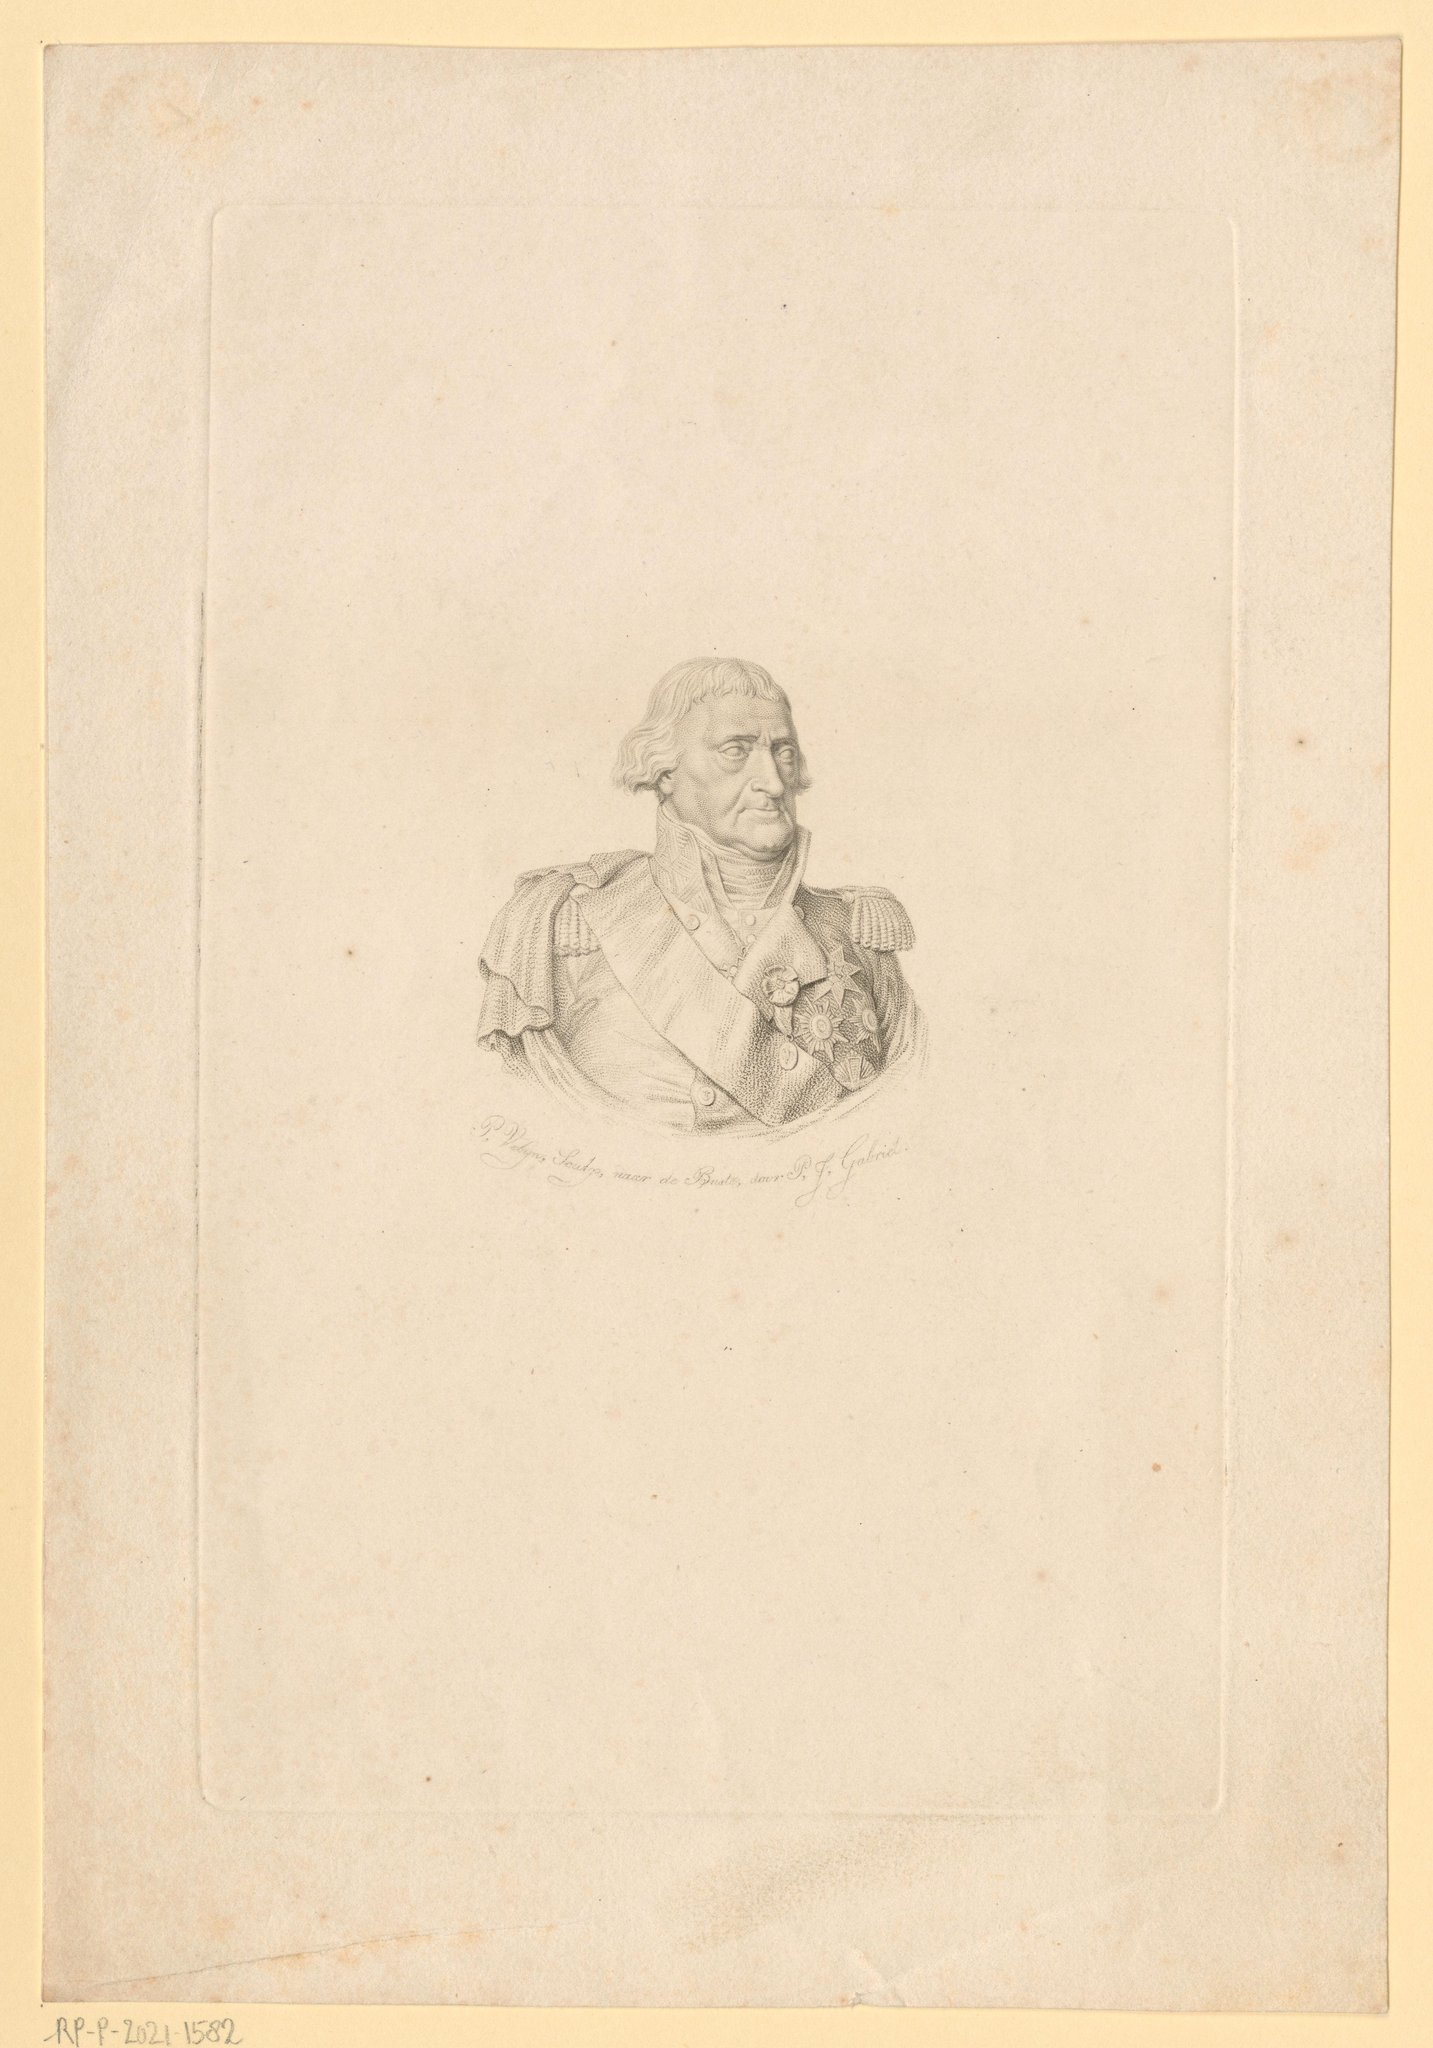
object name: print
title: Portretbuste van jonkheer Jan Hendrik van Kinsbergen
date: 1797-1836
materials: paper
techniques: stippling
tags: jonkheer jan hendrik van kinsbergen, historical persons